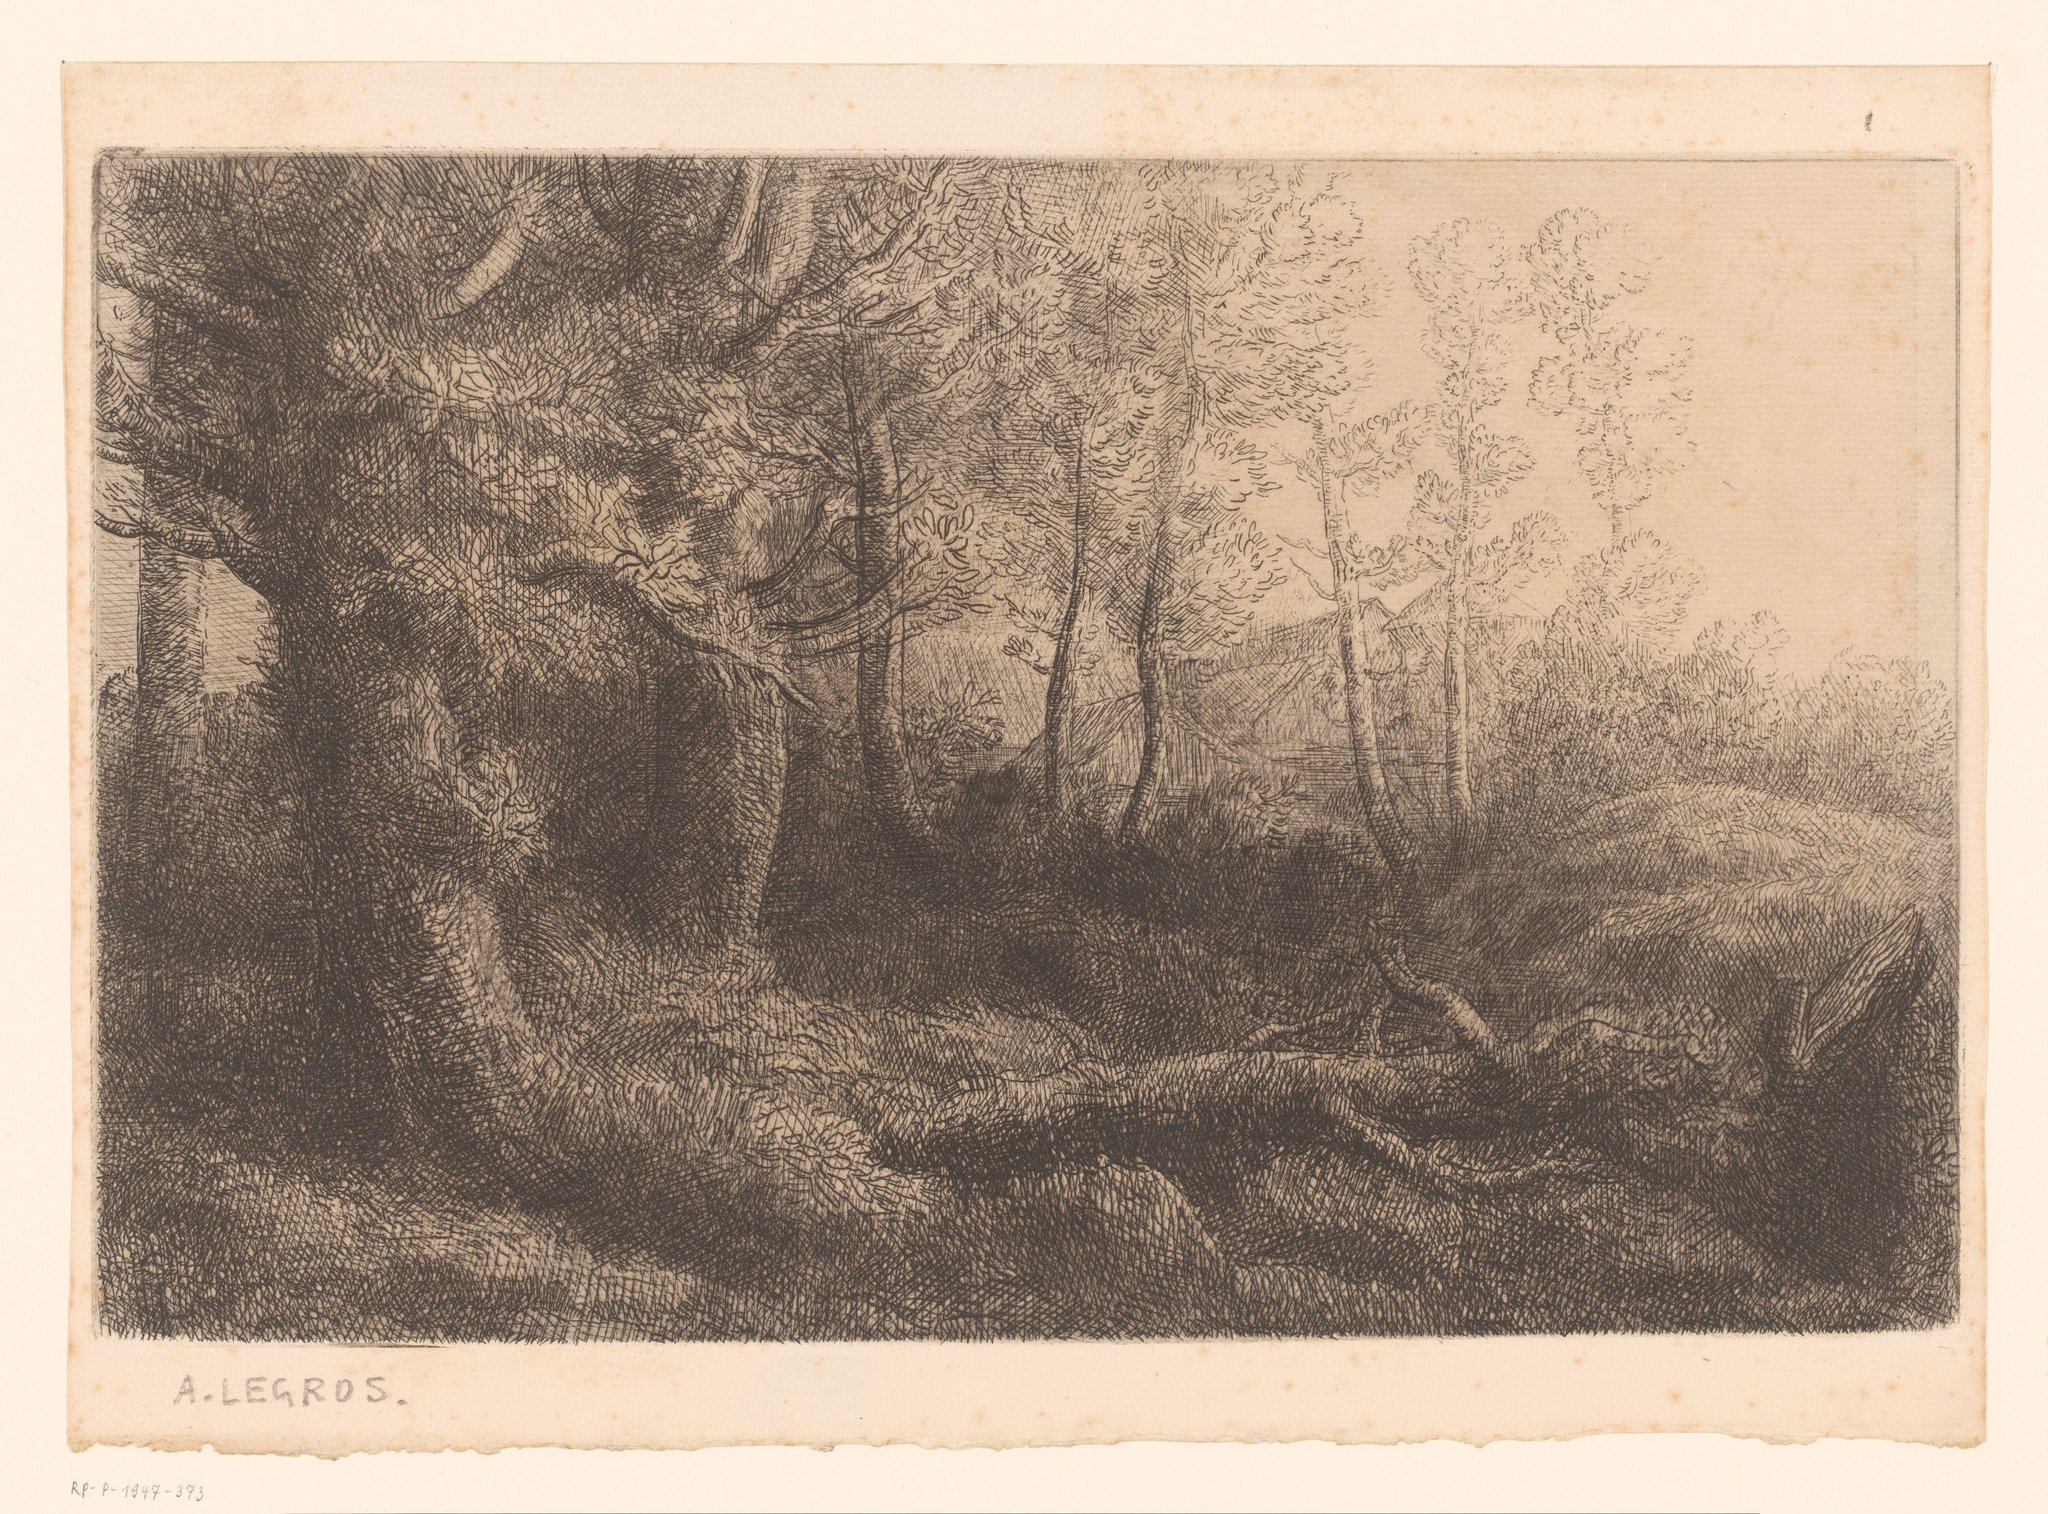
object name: print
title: Bosgezicht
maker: alphonse legros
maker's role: print maker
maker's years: 1837-1911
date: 1847-1911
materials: paper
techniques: drypoint, engraving, etching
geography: france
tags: forest, wood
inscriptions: collector's mark: Lugt 2228